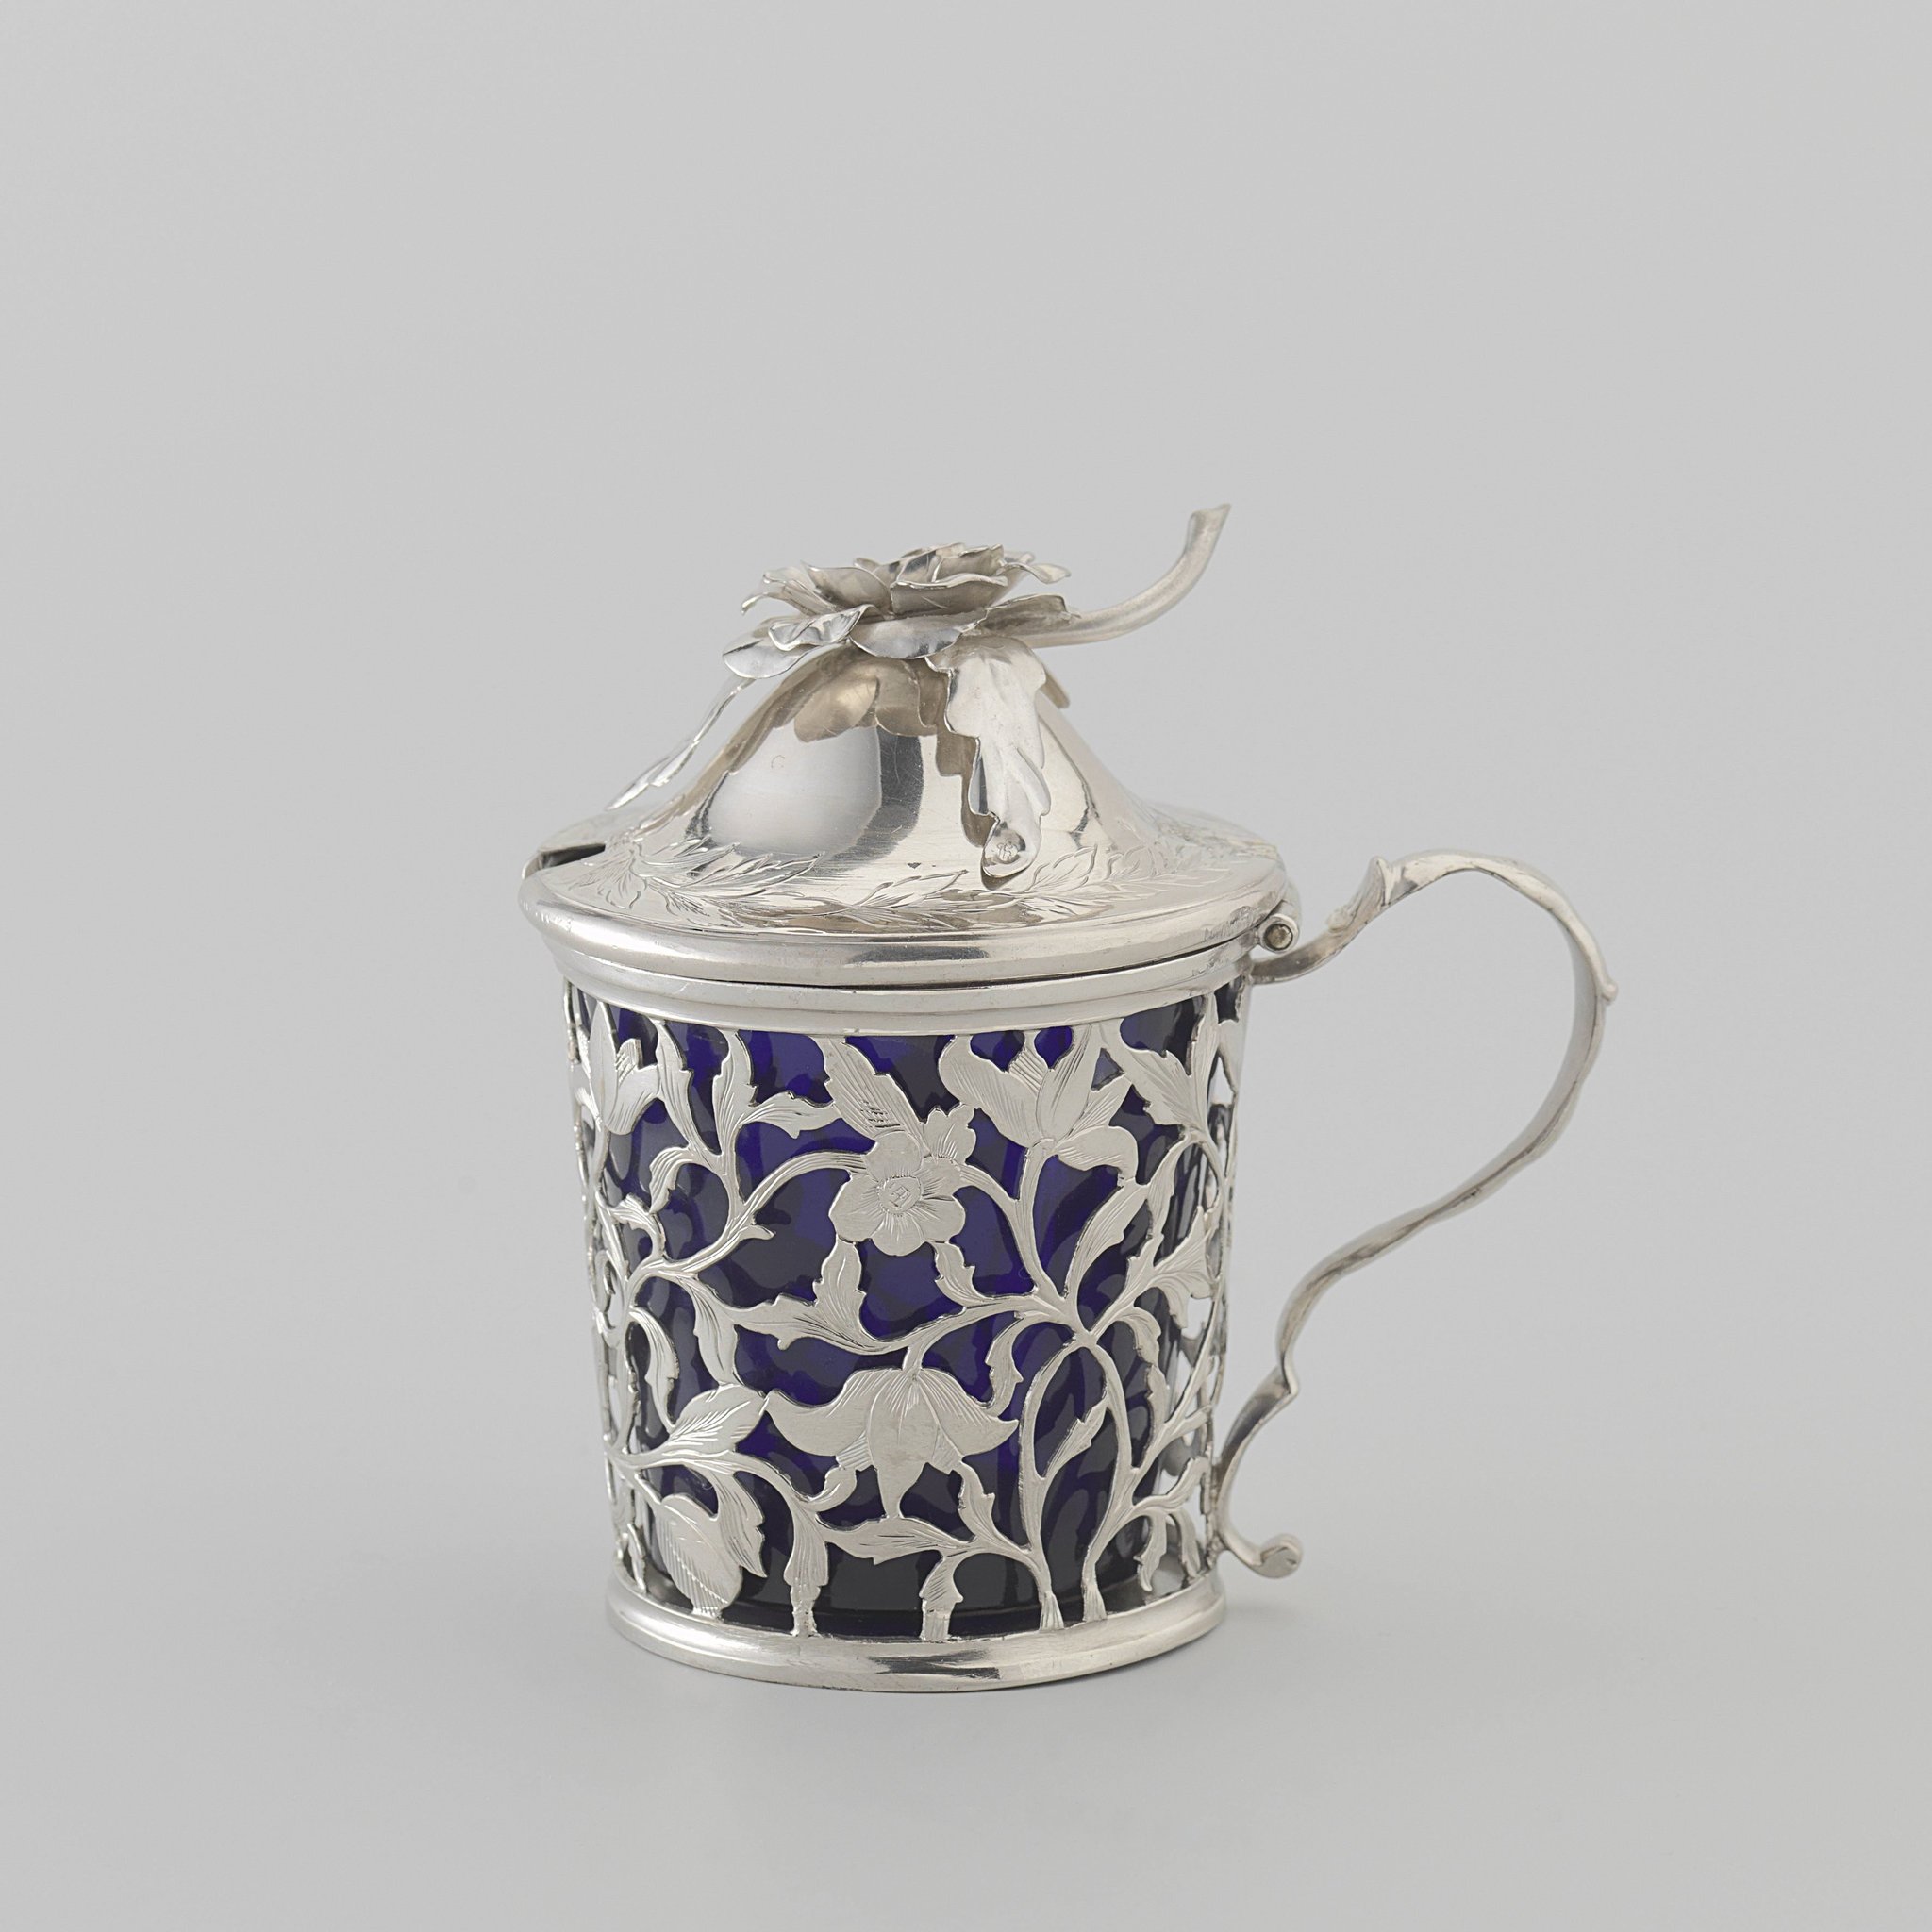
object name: mustard pot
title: Mosterdpot met opengewerkte wand met bloemtakken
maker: Anonymous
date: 1773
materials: glass, silver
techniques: embroidery, engraving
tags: foliage, tendrils, branches ~ ornament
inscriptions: duty mark: ‘I’, maker's mark, date letter: ‘O’, duty mark, town mark, alloy mark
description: Pair of mustard pots. Silver. Amsterdam, 1773 - 1774, attributed to Gerrit Willem Angermond.